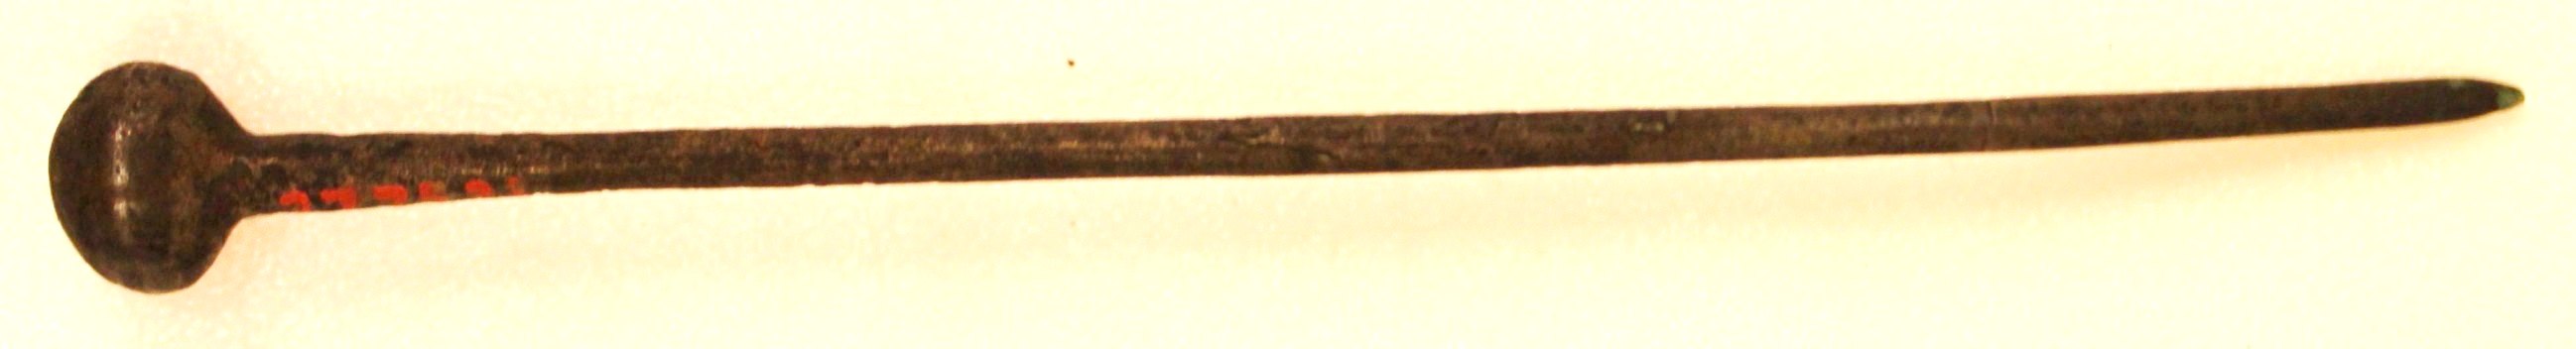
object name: pin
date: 401-800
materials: bronze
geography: palestine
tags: pins